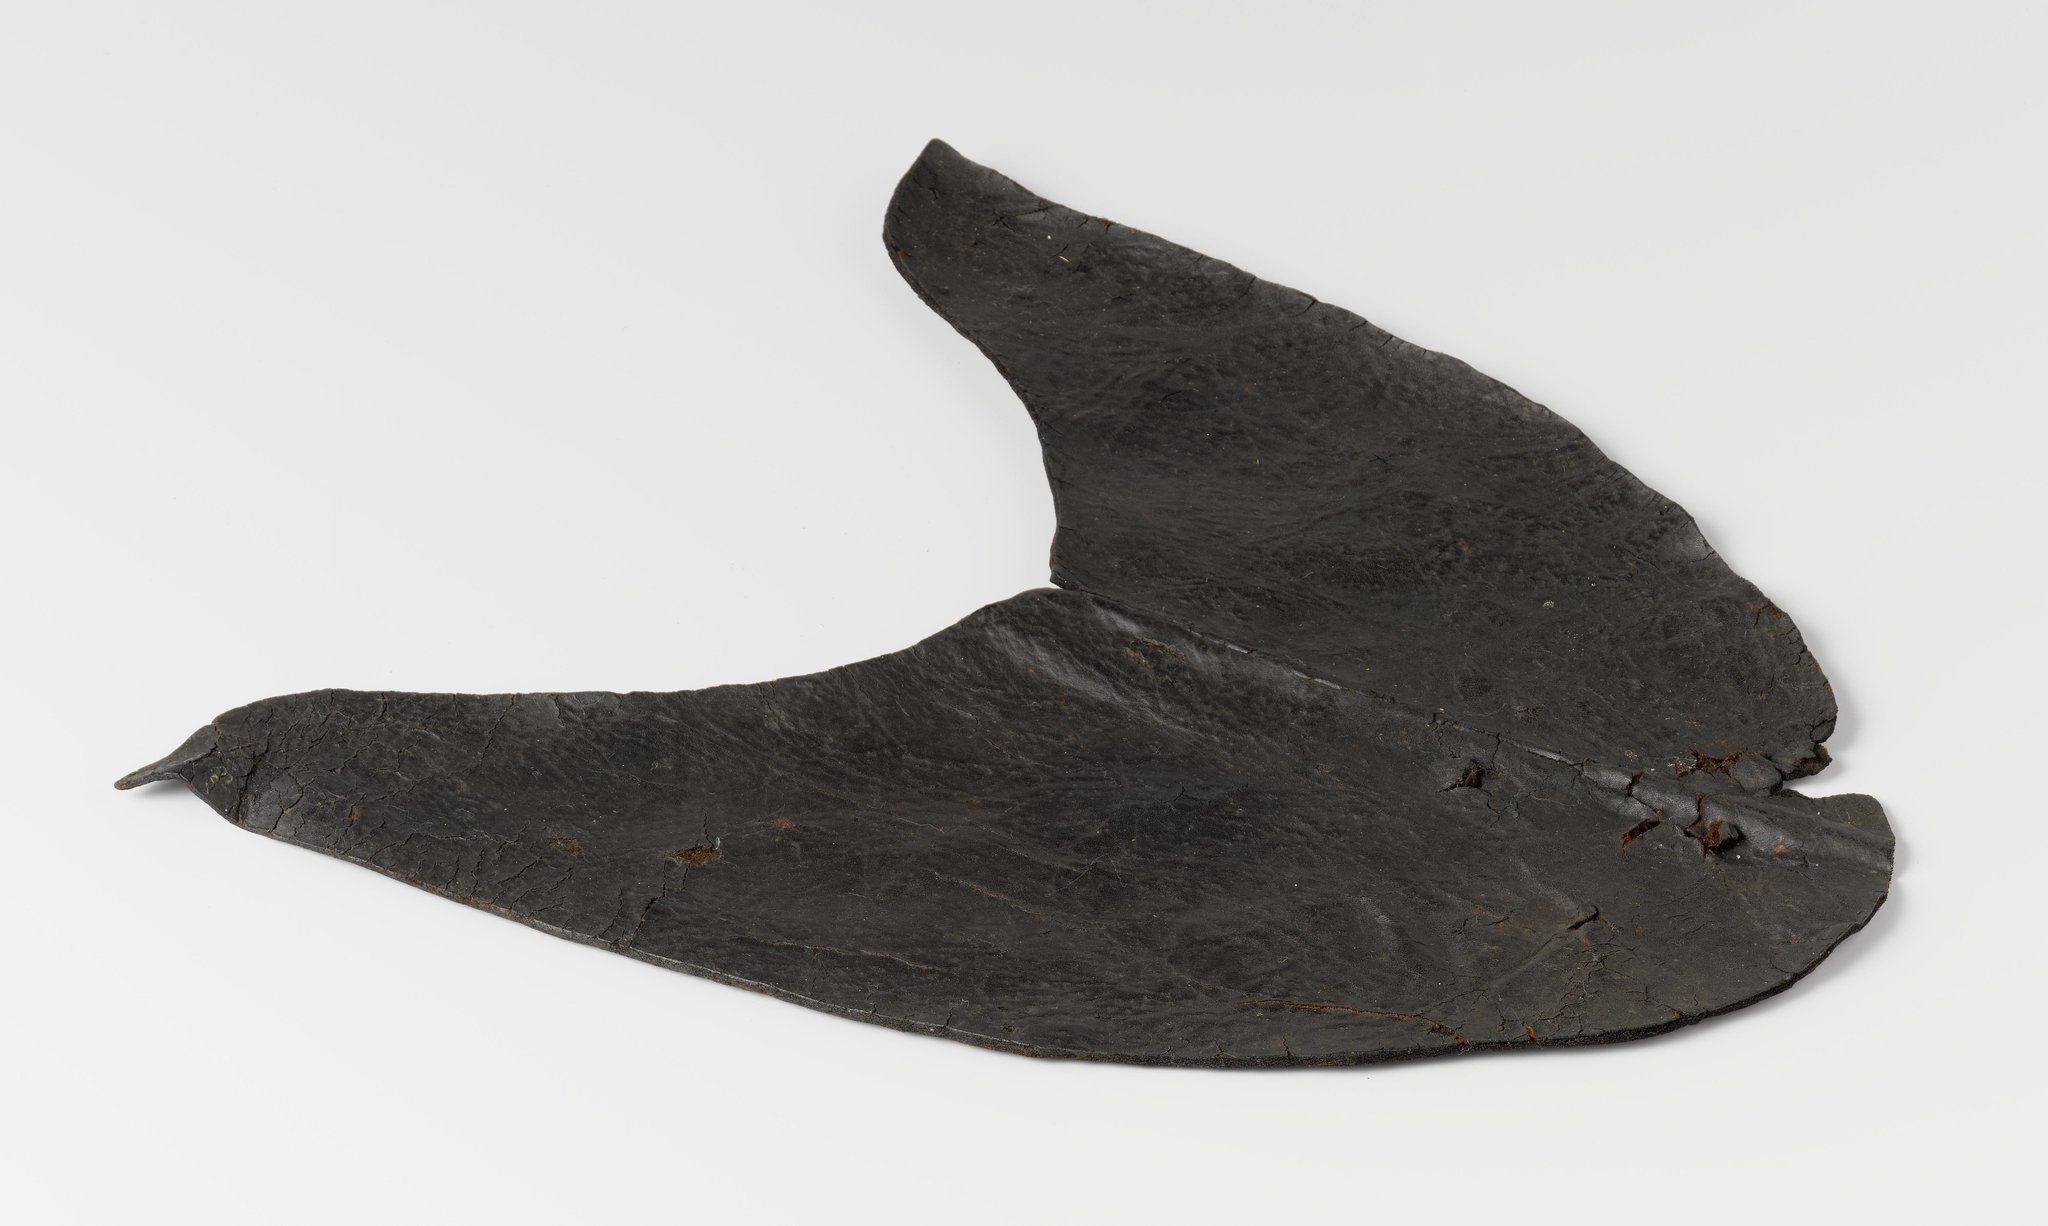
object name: shoe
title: Stuk leer, vermoedelijk in de vorm van een nog niet opgemaakte voorschoen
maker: Anonymous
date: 1590-1596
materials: leather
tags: willem barendsz., amsterdam, jacob van heemskerck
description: Stuk leder, Russisch? Vermoedelijk heeft het stuk leer de vorm van een nog niet opgemaakte voorschoen, een tripklomp.